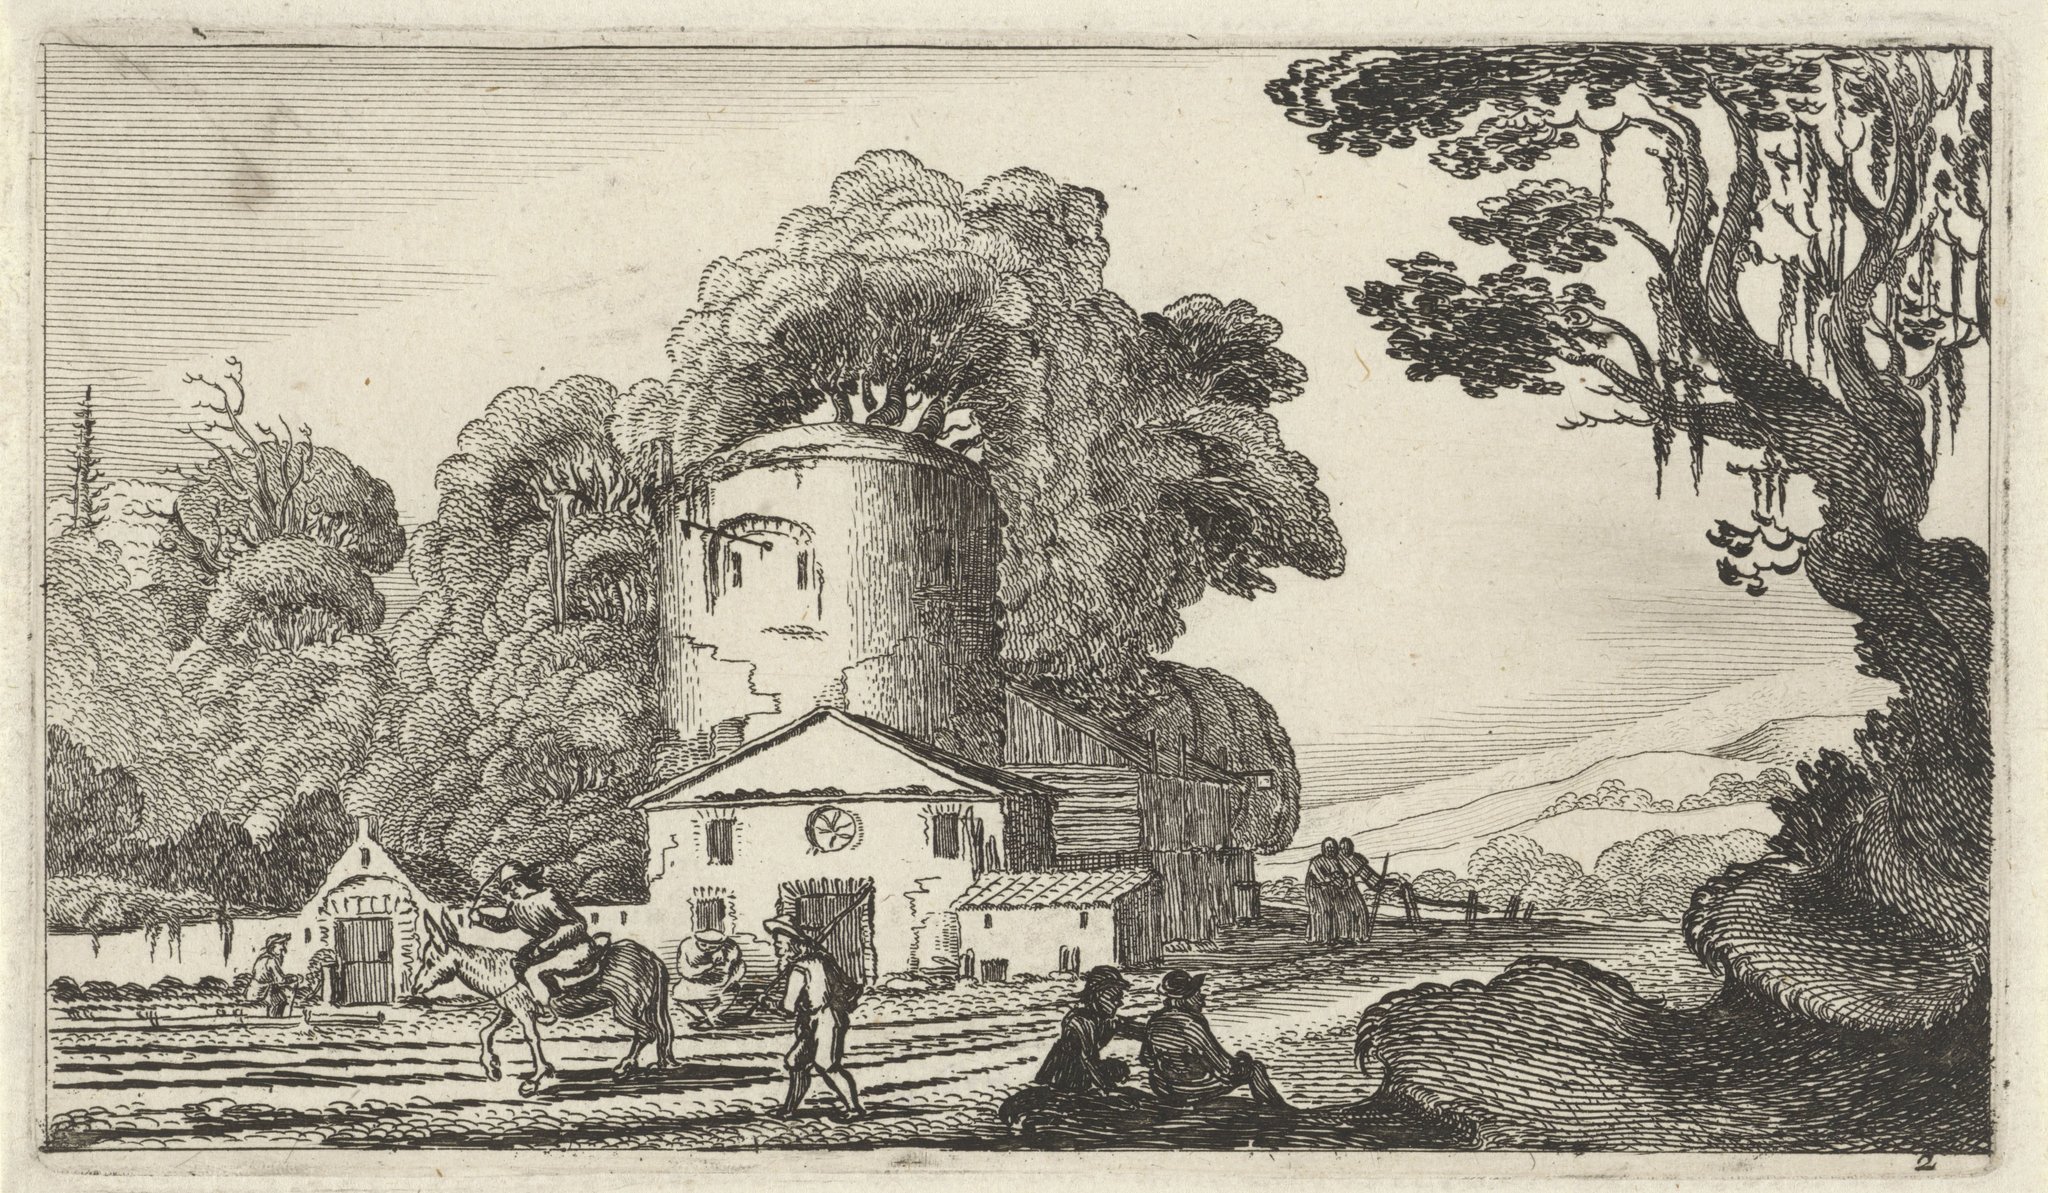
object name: print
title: Twaalf landschappen met figuren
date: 1624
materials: paper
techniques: etching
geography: amsterdam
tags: riding a horse, ass, or mule; rider, horseman, 'en route', traveller under way, farm (building)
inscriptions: collector's mark: Lugt 2228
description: Gezicht op een glooiend landschap met een toren en een boerderij. Op de voorgrond een ruiter, een wandelaar en twee mannen die in de schaduw zitten. De prent maakt deel uit van een serie met twaalf landschappen met figuren.